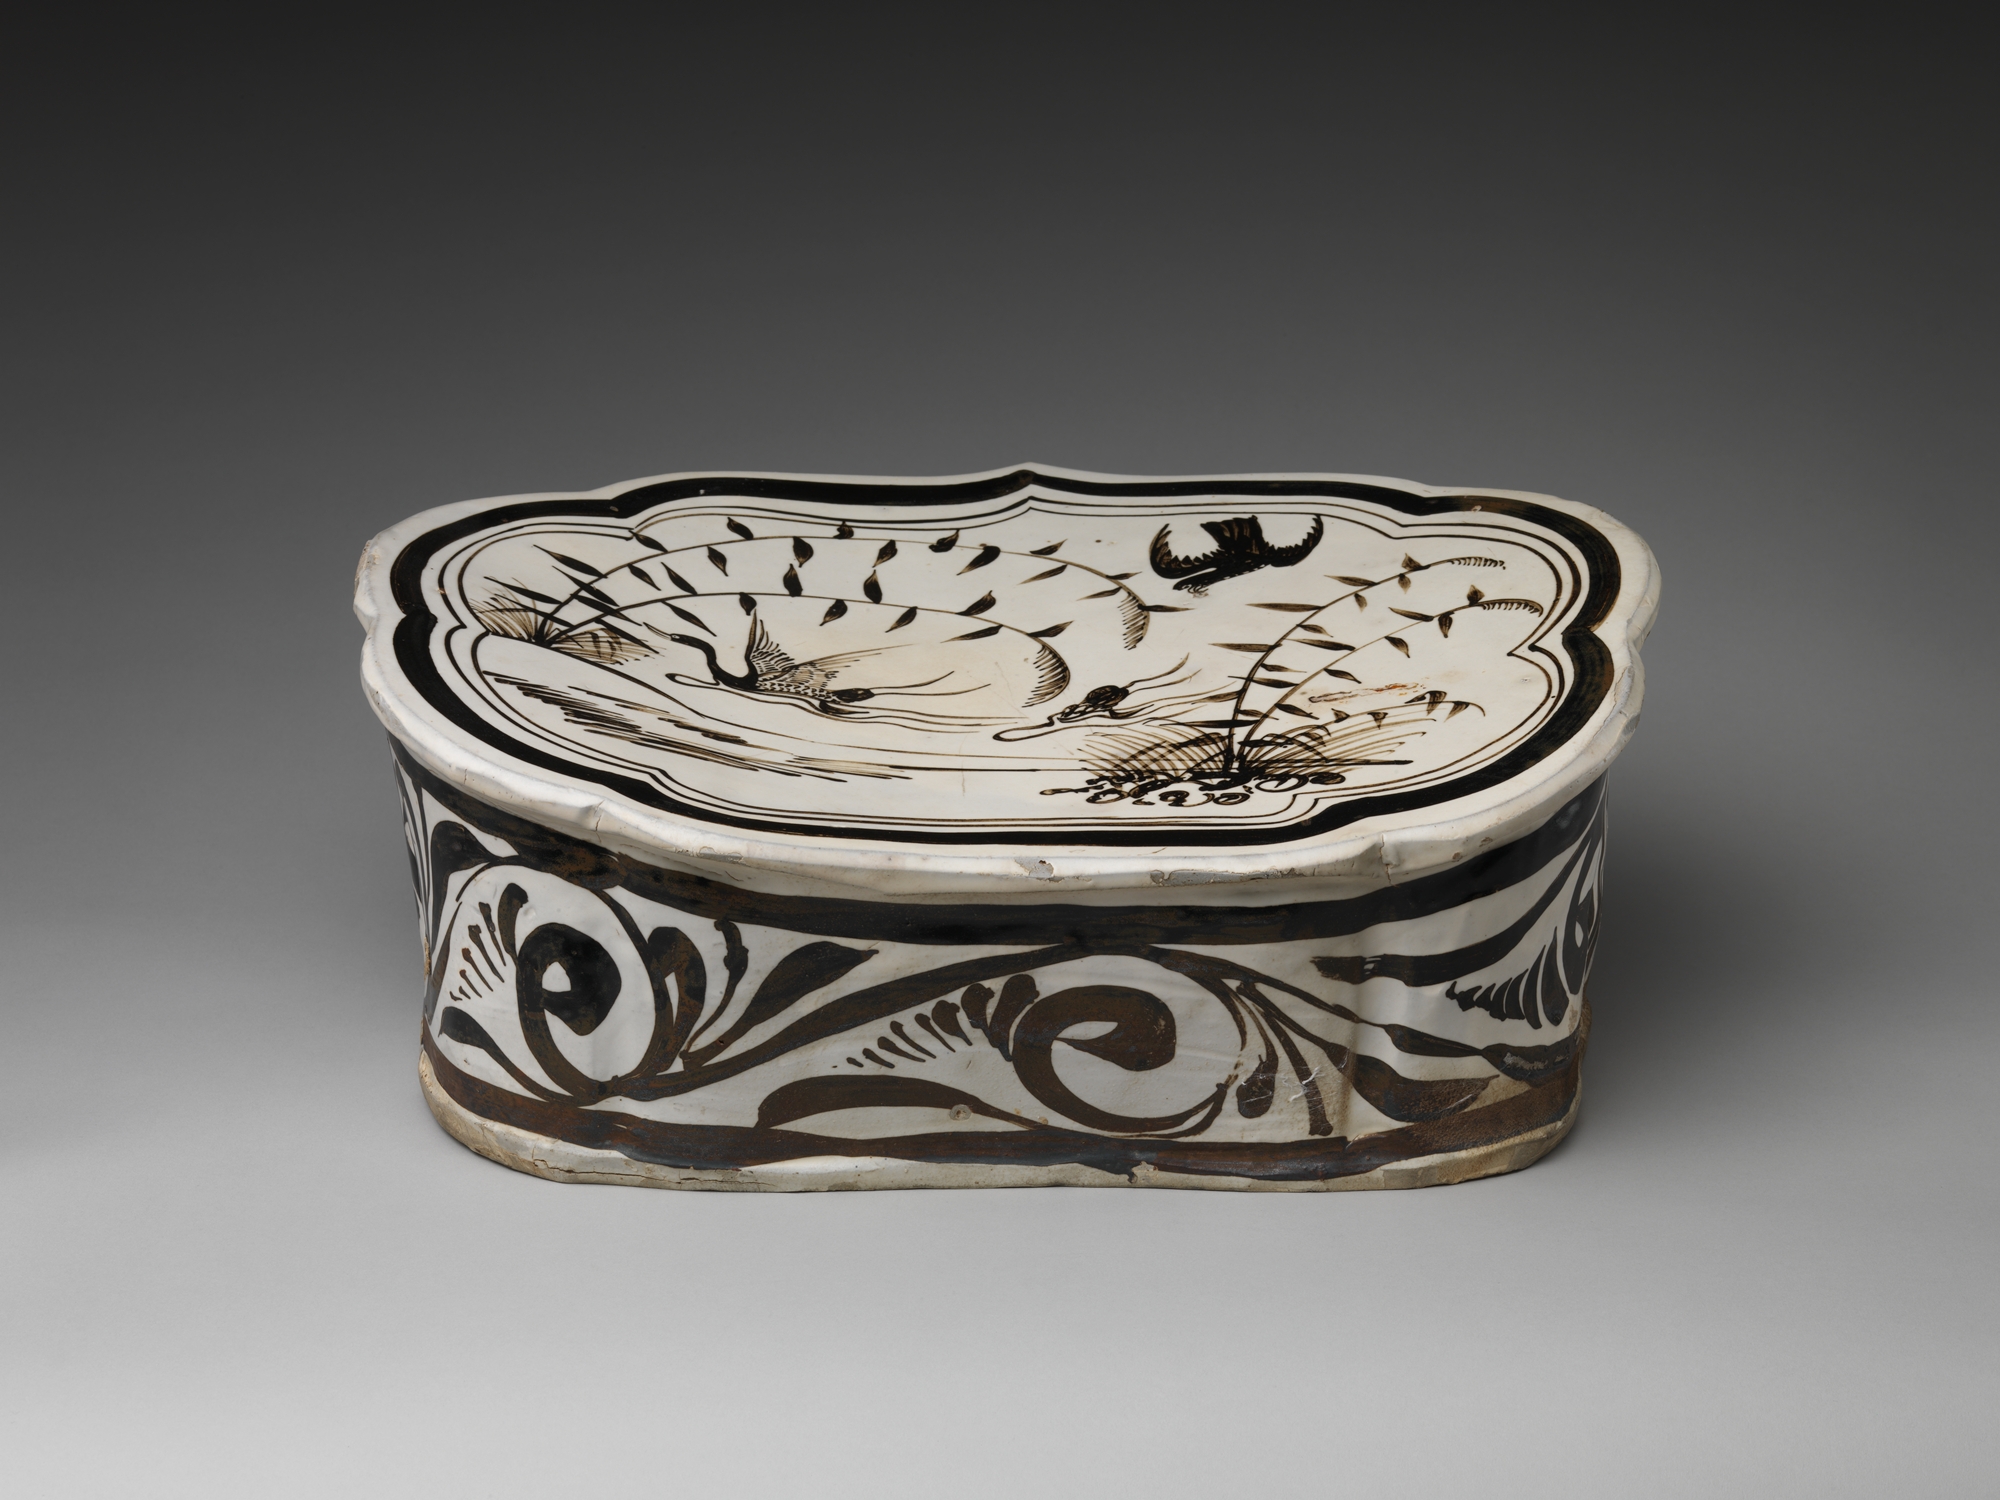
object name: pillow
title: Pillow with a falcon attacking a swan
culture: chinese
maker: zhang family workshop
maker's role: artist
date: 1101-1300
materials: glaze, pigment, stoneware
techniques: painting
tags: hawks,swans